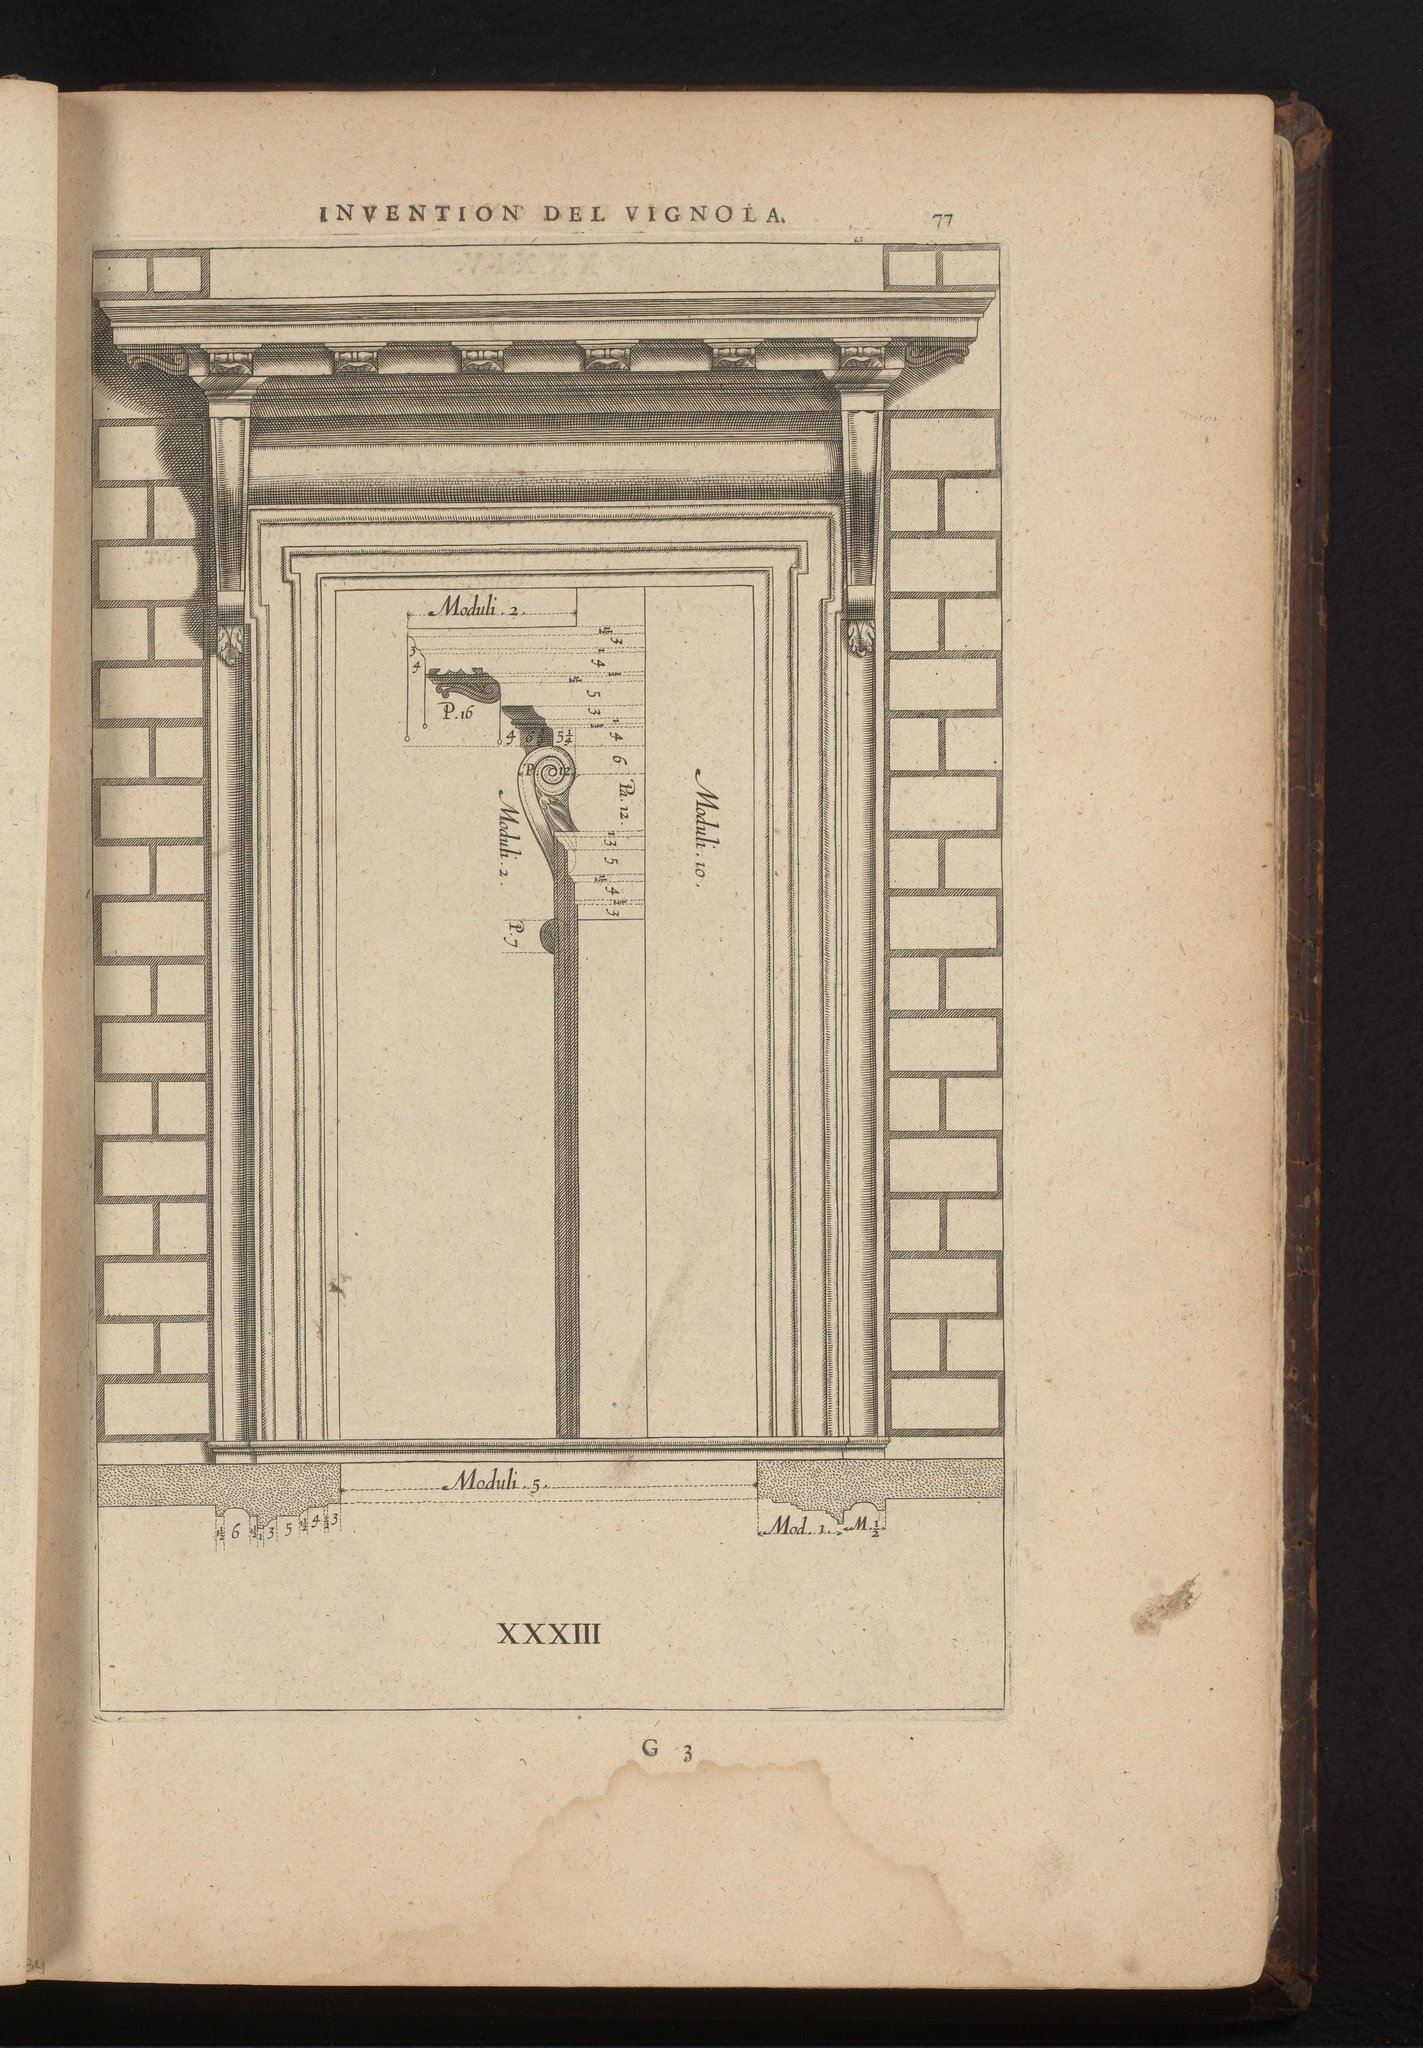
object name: print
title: Poort van de basiliek van San Lorenzo in Damaso te Rome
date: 1640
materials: paper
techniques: engraving, letterpress printing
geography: amsterdam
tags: architecture, exterior ~ representation of a building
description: Prent uit: Vignola, Giacomo Barozzi da. Regola delli cinque ordini d'architettura (...). Amsterdam: Johannes Willemszoon en Cornelis Blaeu, 1640, p. 77.